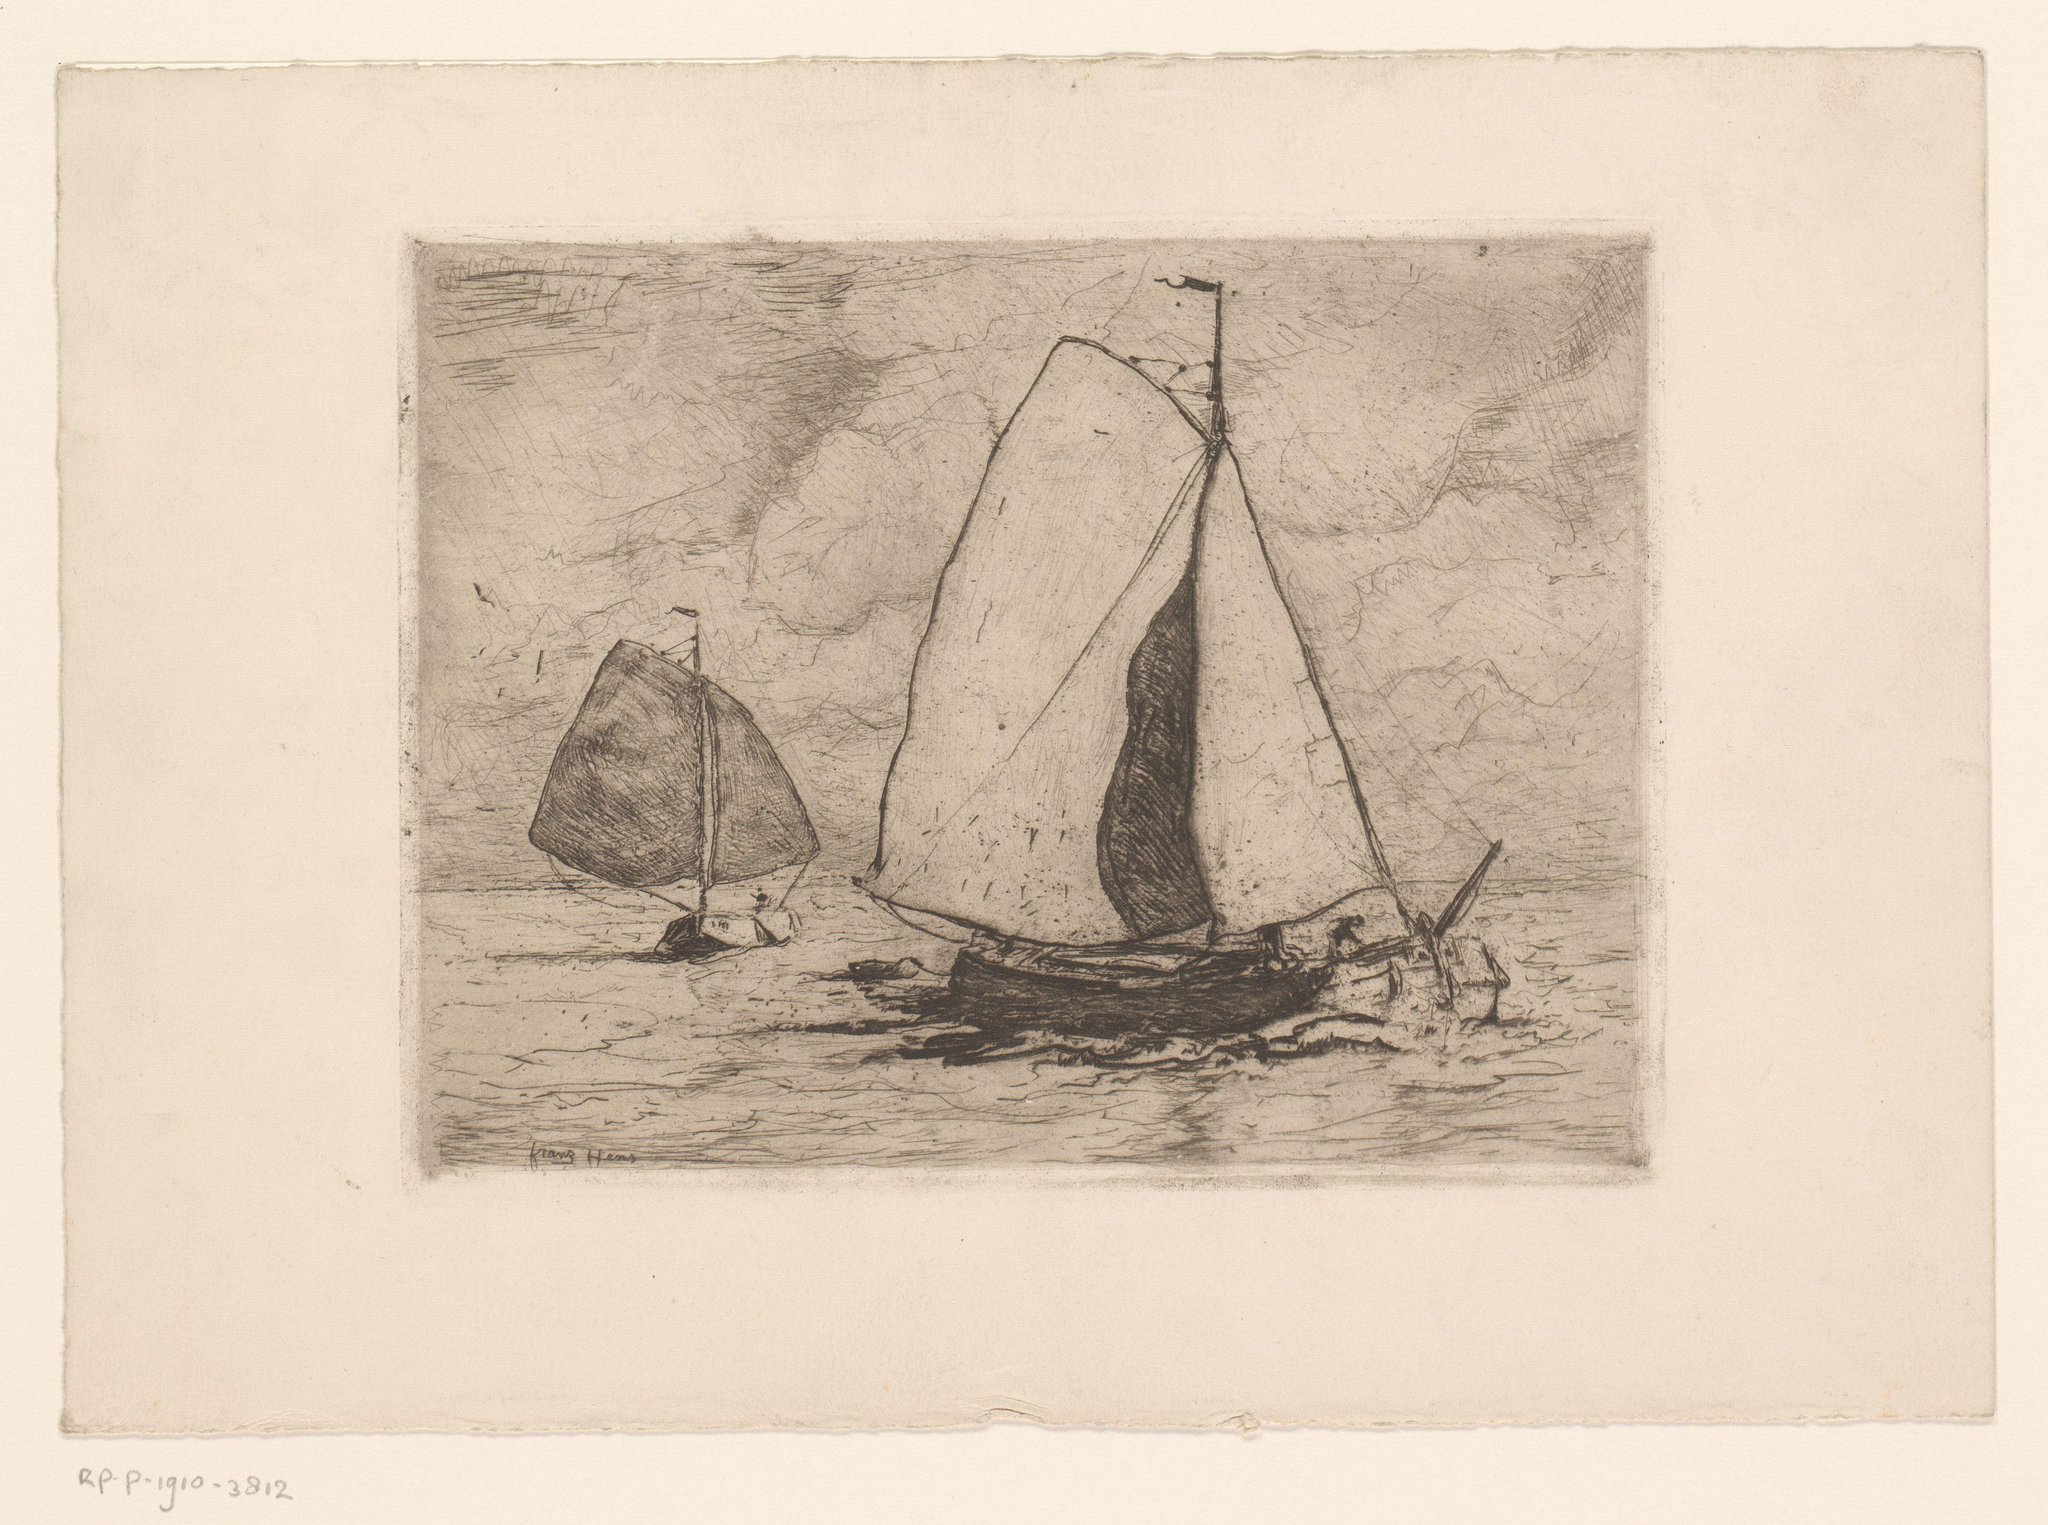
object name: print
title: Twee zeilschepen op het water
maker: frans hens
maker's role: print maker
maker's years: 1856-1928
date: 1866-1910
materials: paper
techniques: drypoint, etching, intaglio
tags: sailing-ship, sailing-boat, landscapes with waters, waterscapes, seascapes (in the temperate zone)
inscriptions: collector's mark: Lugt 2228